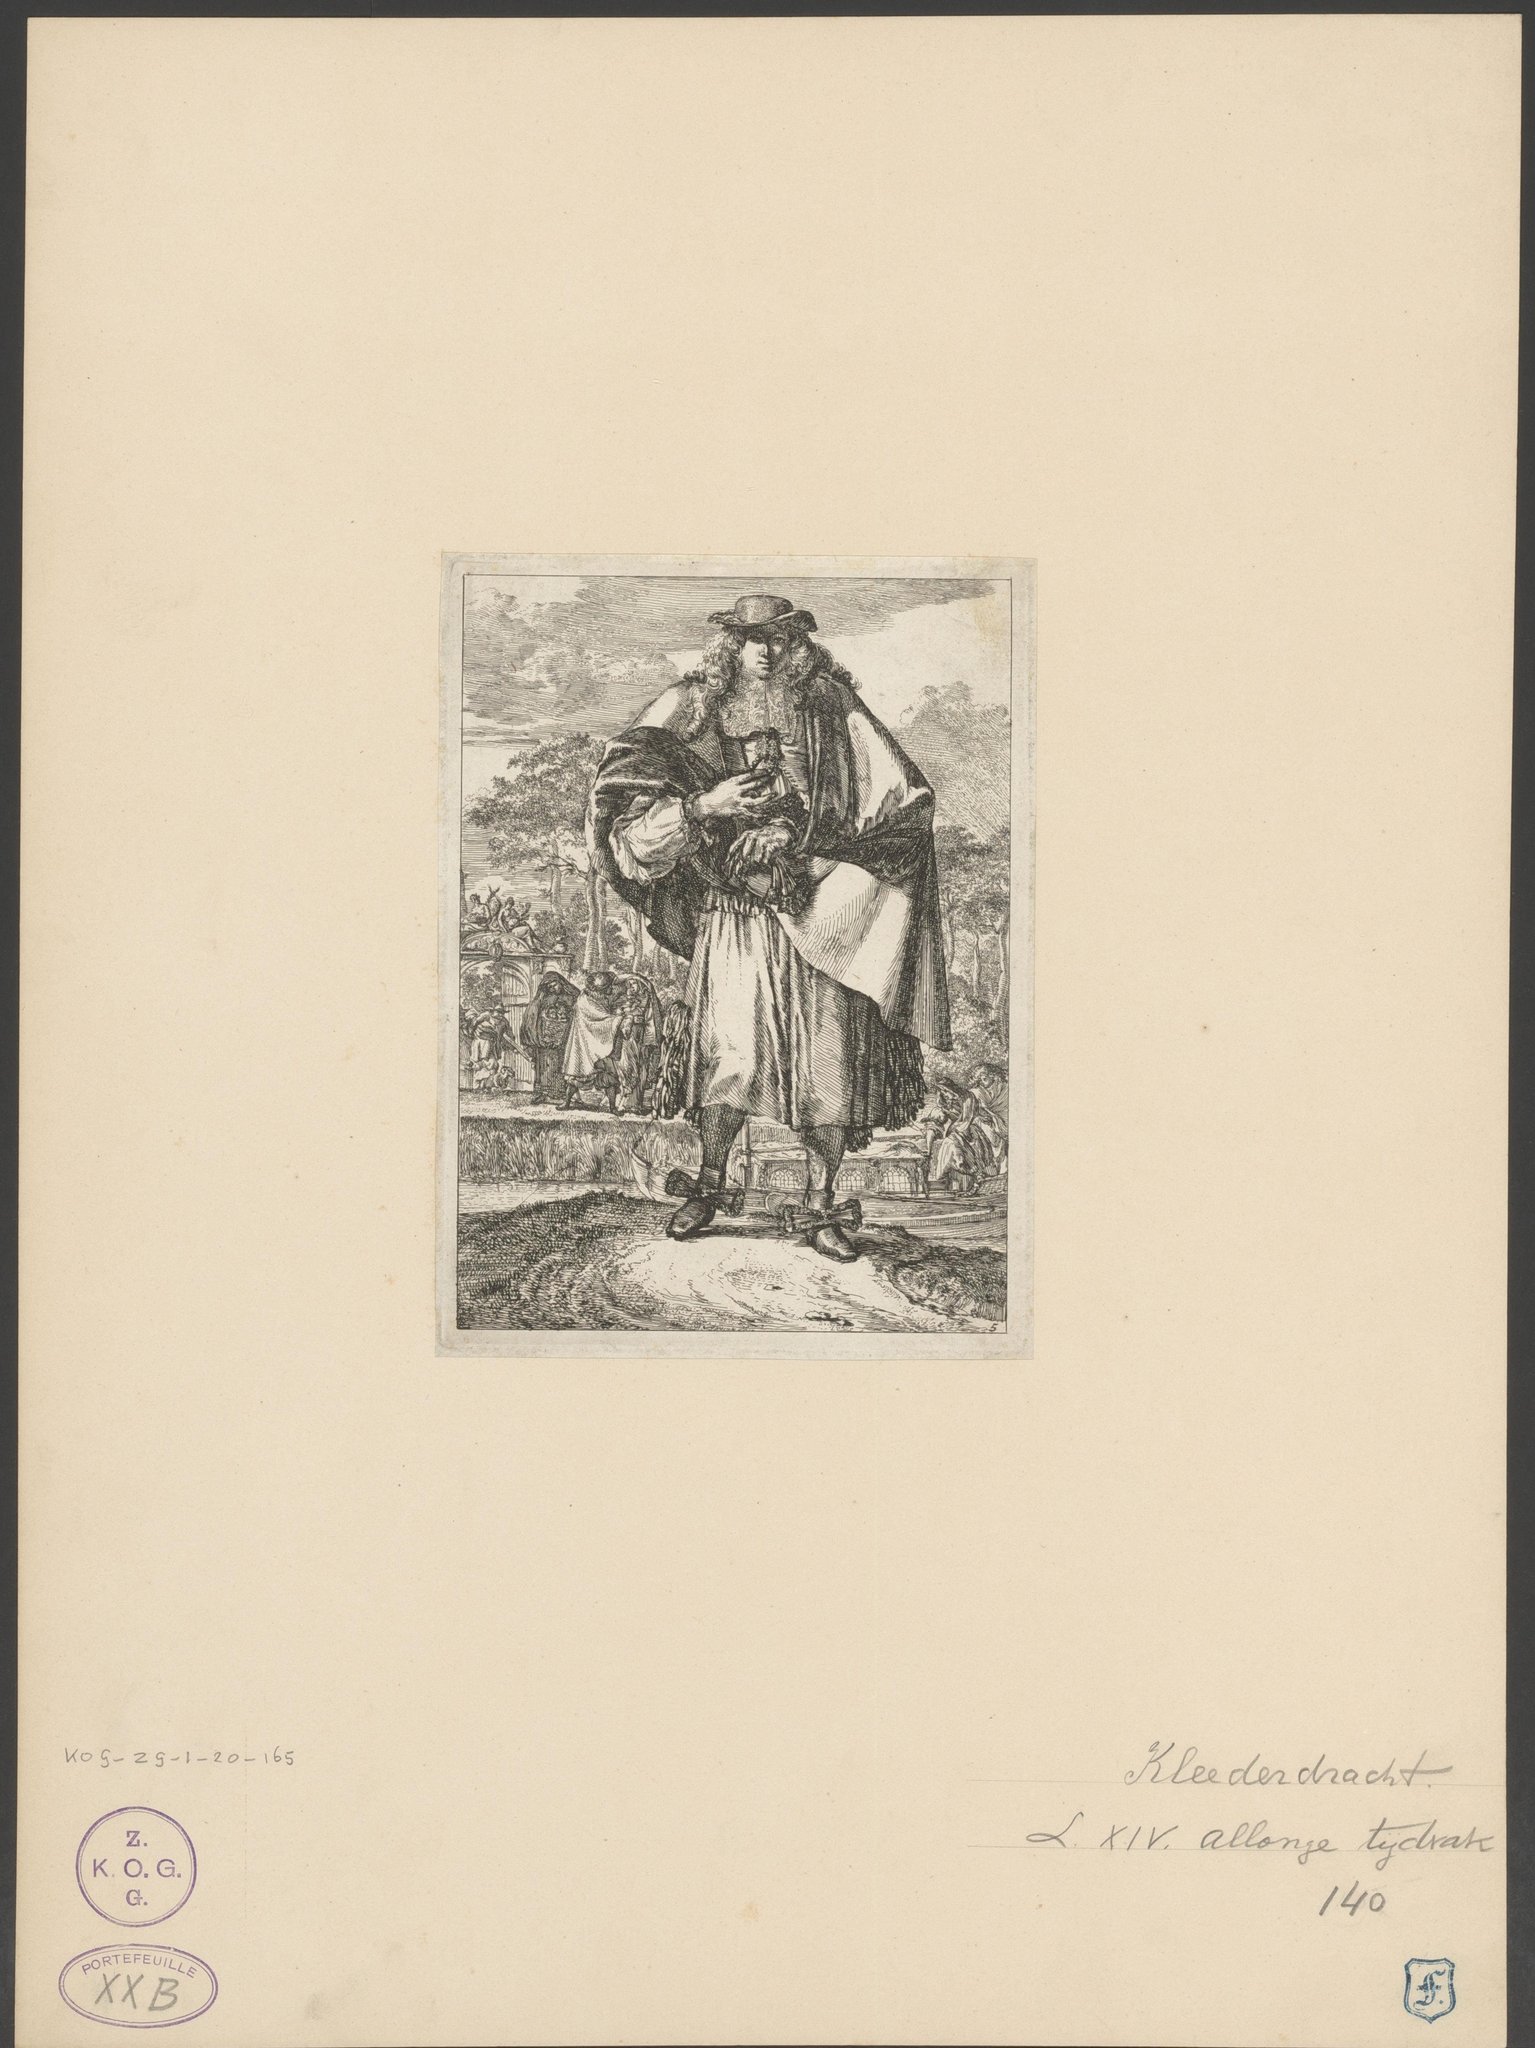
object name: print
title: Figures à la mode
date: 1662-1702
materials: paper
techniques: etching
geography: amsterdam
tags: handkerchief (+ women's clothes), coat (+ men's clothes), head-gear: hat (+ men's clothes), styles of hairdress, fashion plates, shoes, sandals (+ men's clothes), wig, gloves, mittens, etc. (+ men's clothes), trousers, breeches, etc. (petticoat breeches) (+ men's clothes)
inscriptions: collector's mark: Lugt 963, collector's mark: Lugt 963, collector's mark: Lugt 1641, stamp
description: Man gekleed in rhingrave (wijde 'broekrok'), versierd met lussen en linten aan de zijkant. Innocent met grote bef, waaroverheen een schoudermantel. Op de lange krullende haren een hoed met platte bol. In zijn linkerhand een handschoen. Schoenen met brede strikken. Op de achtergrond mensen die in een boot stappen. Rechtsonder genummerd: 5. Onderwerpsrubrieken binnen de Atlas Zeden en Gewoonten: Zeden en Gewoonten in Engeren Zin, De Kleeding, Kleederdrachten (tijdvakken), Lodewijk XIV (1650 – 1720). Het allonge tijdvak).